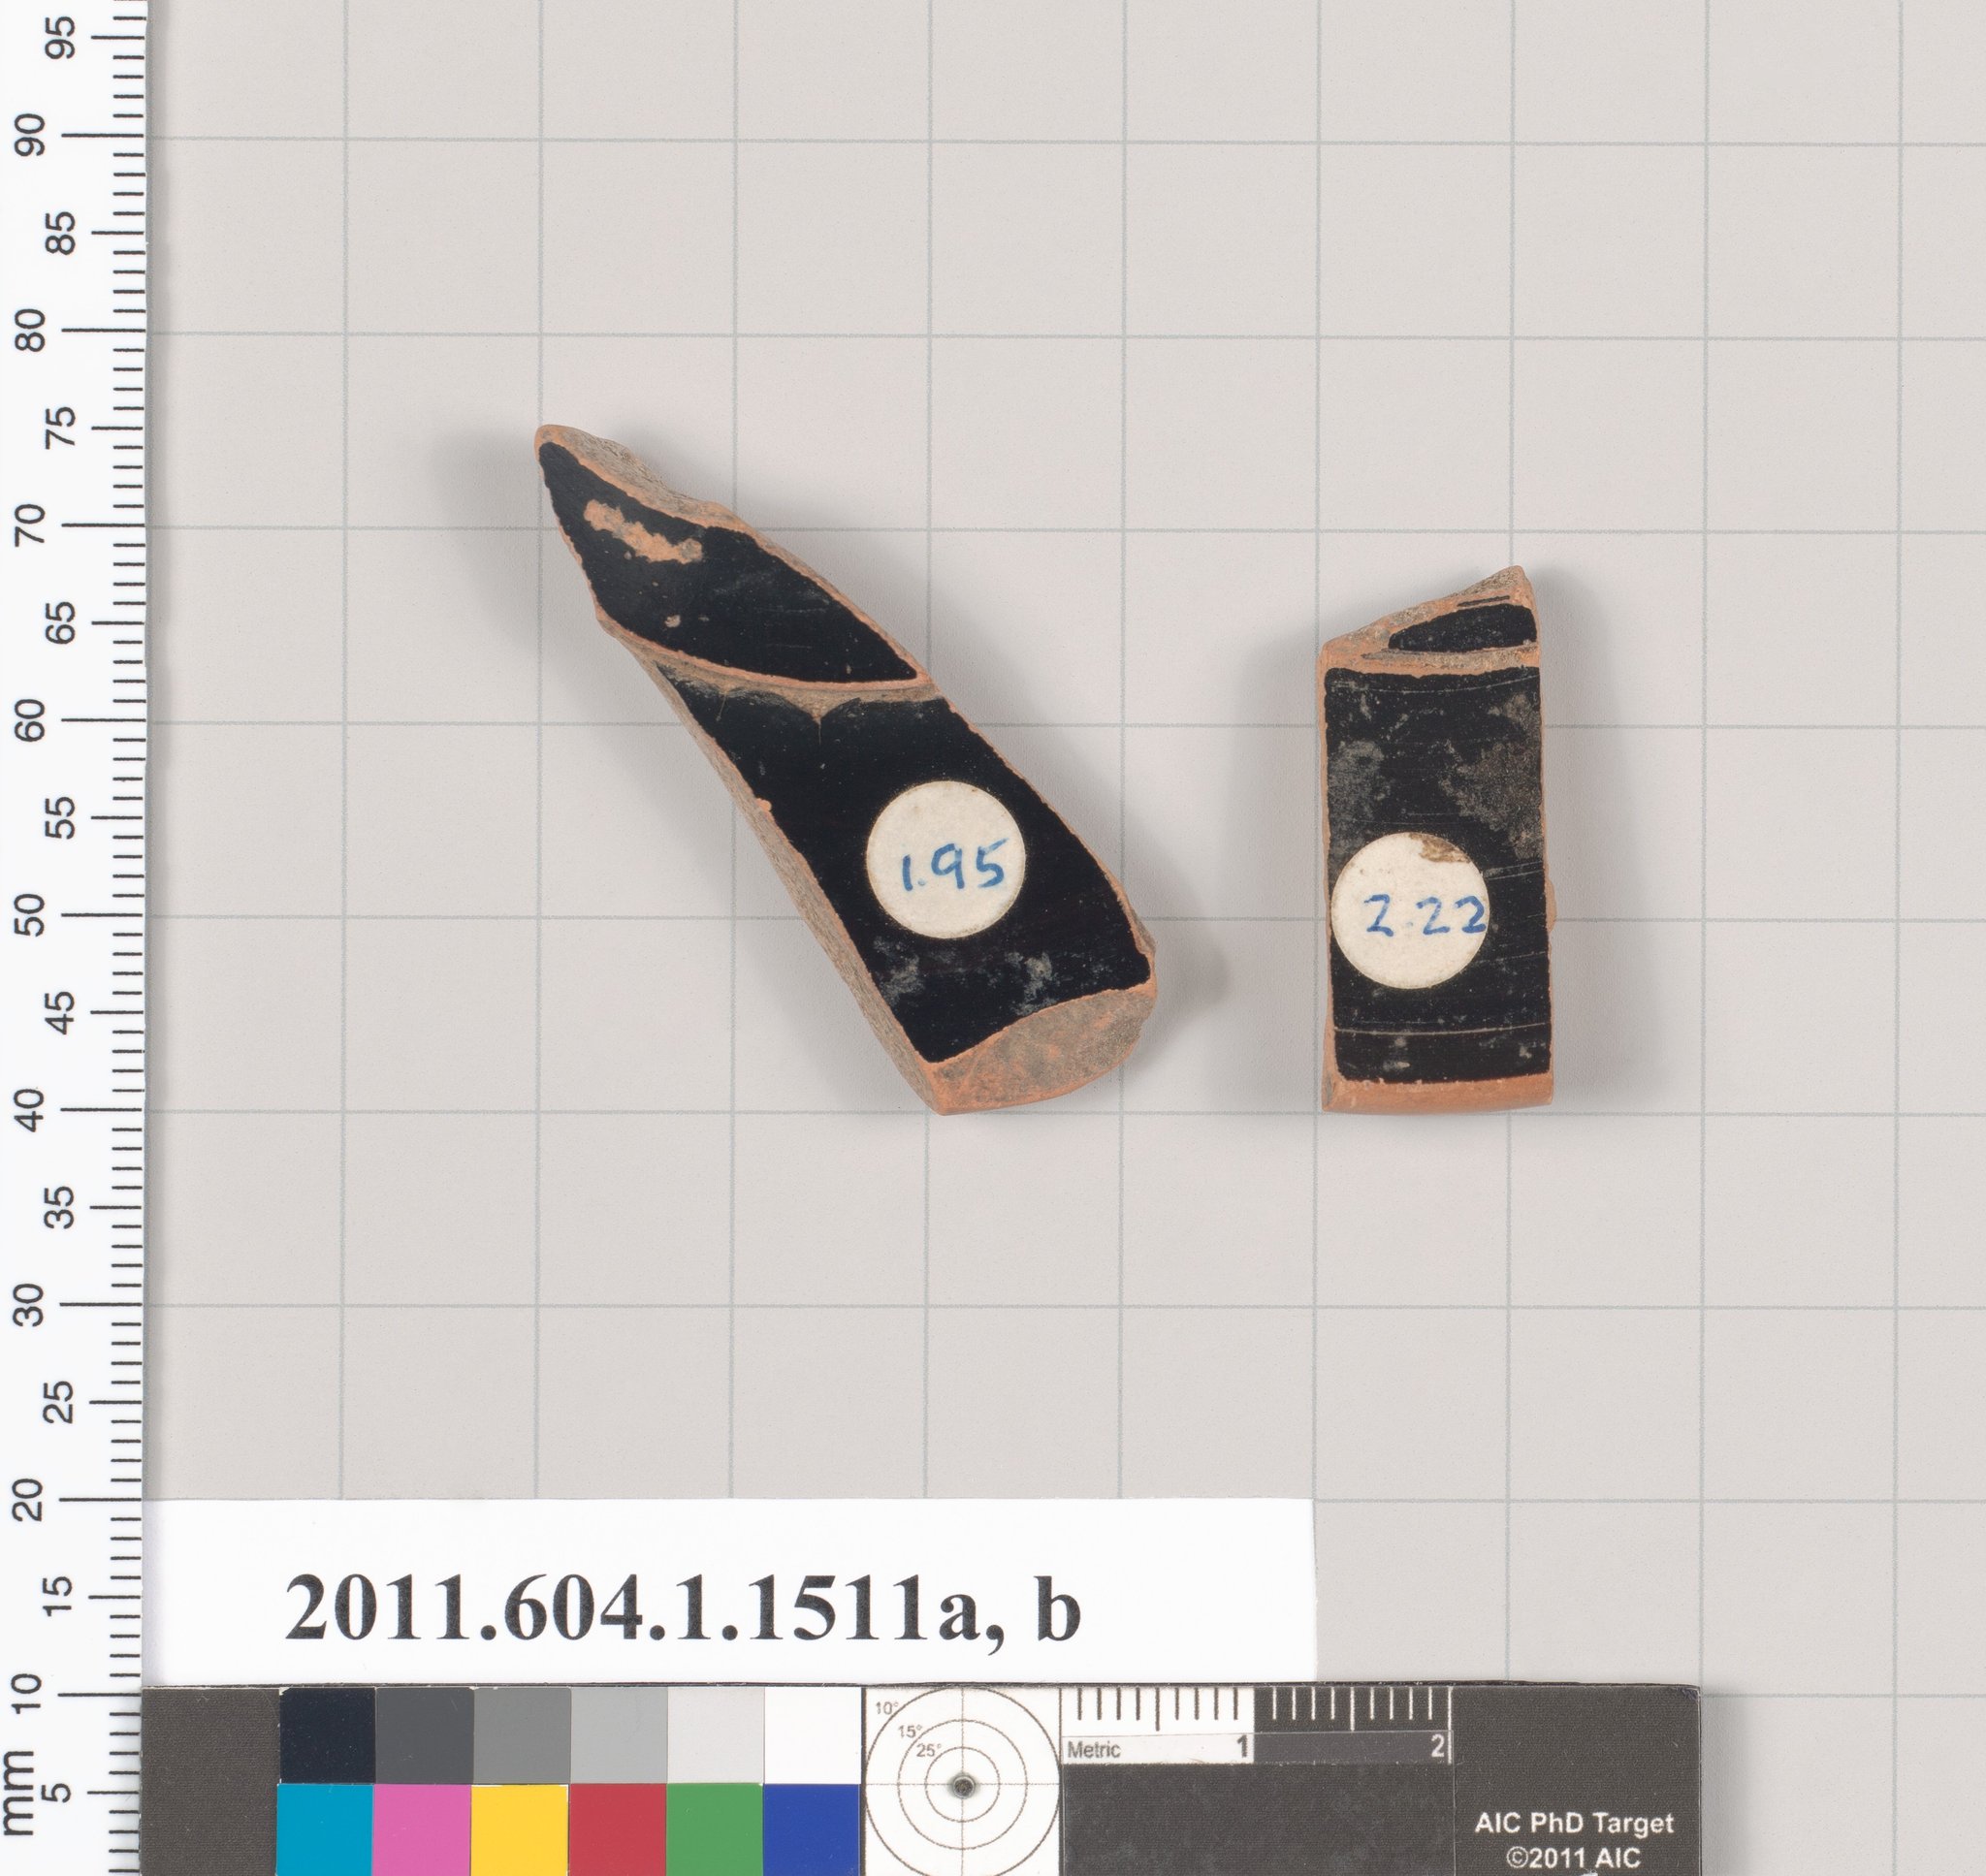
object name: kylix fragment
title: Terracotta fragments of kylikes (drinking cups)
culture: greek, attic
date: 500-401 BCE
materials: terracotta